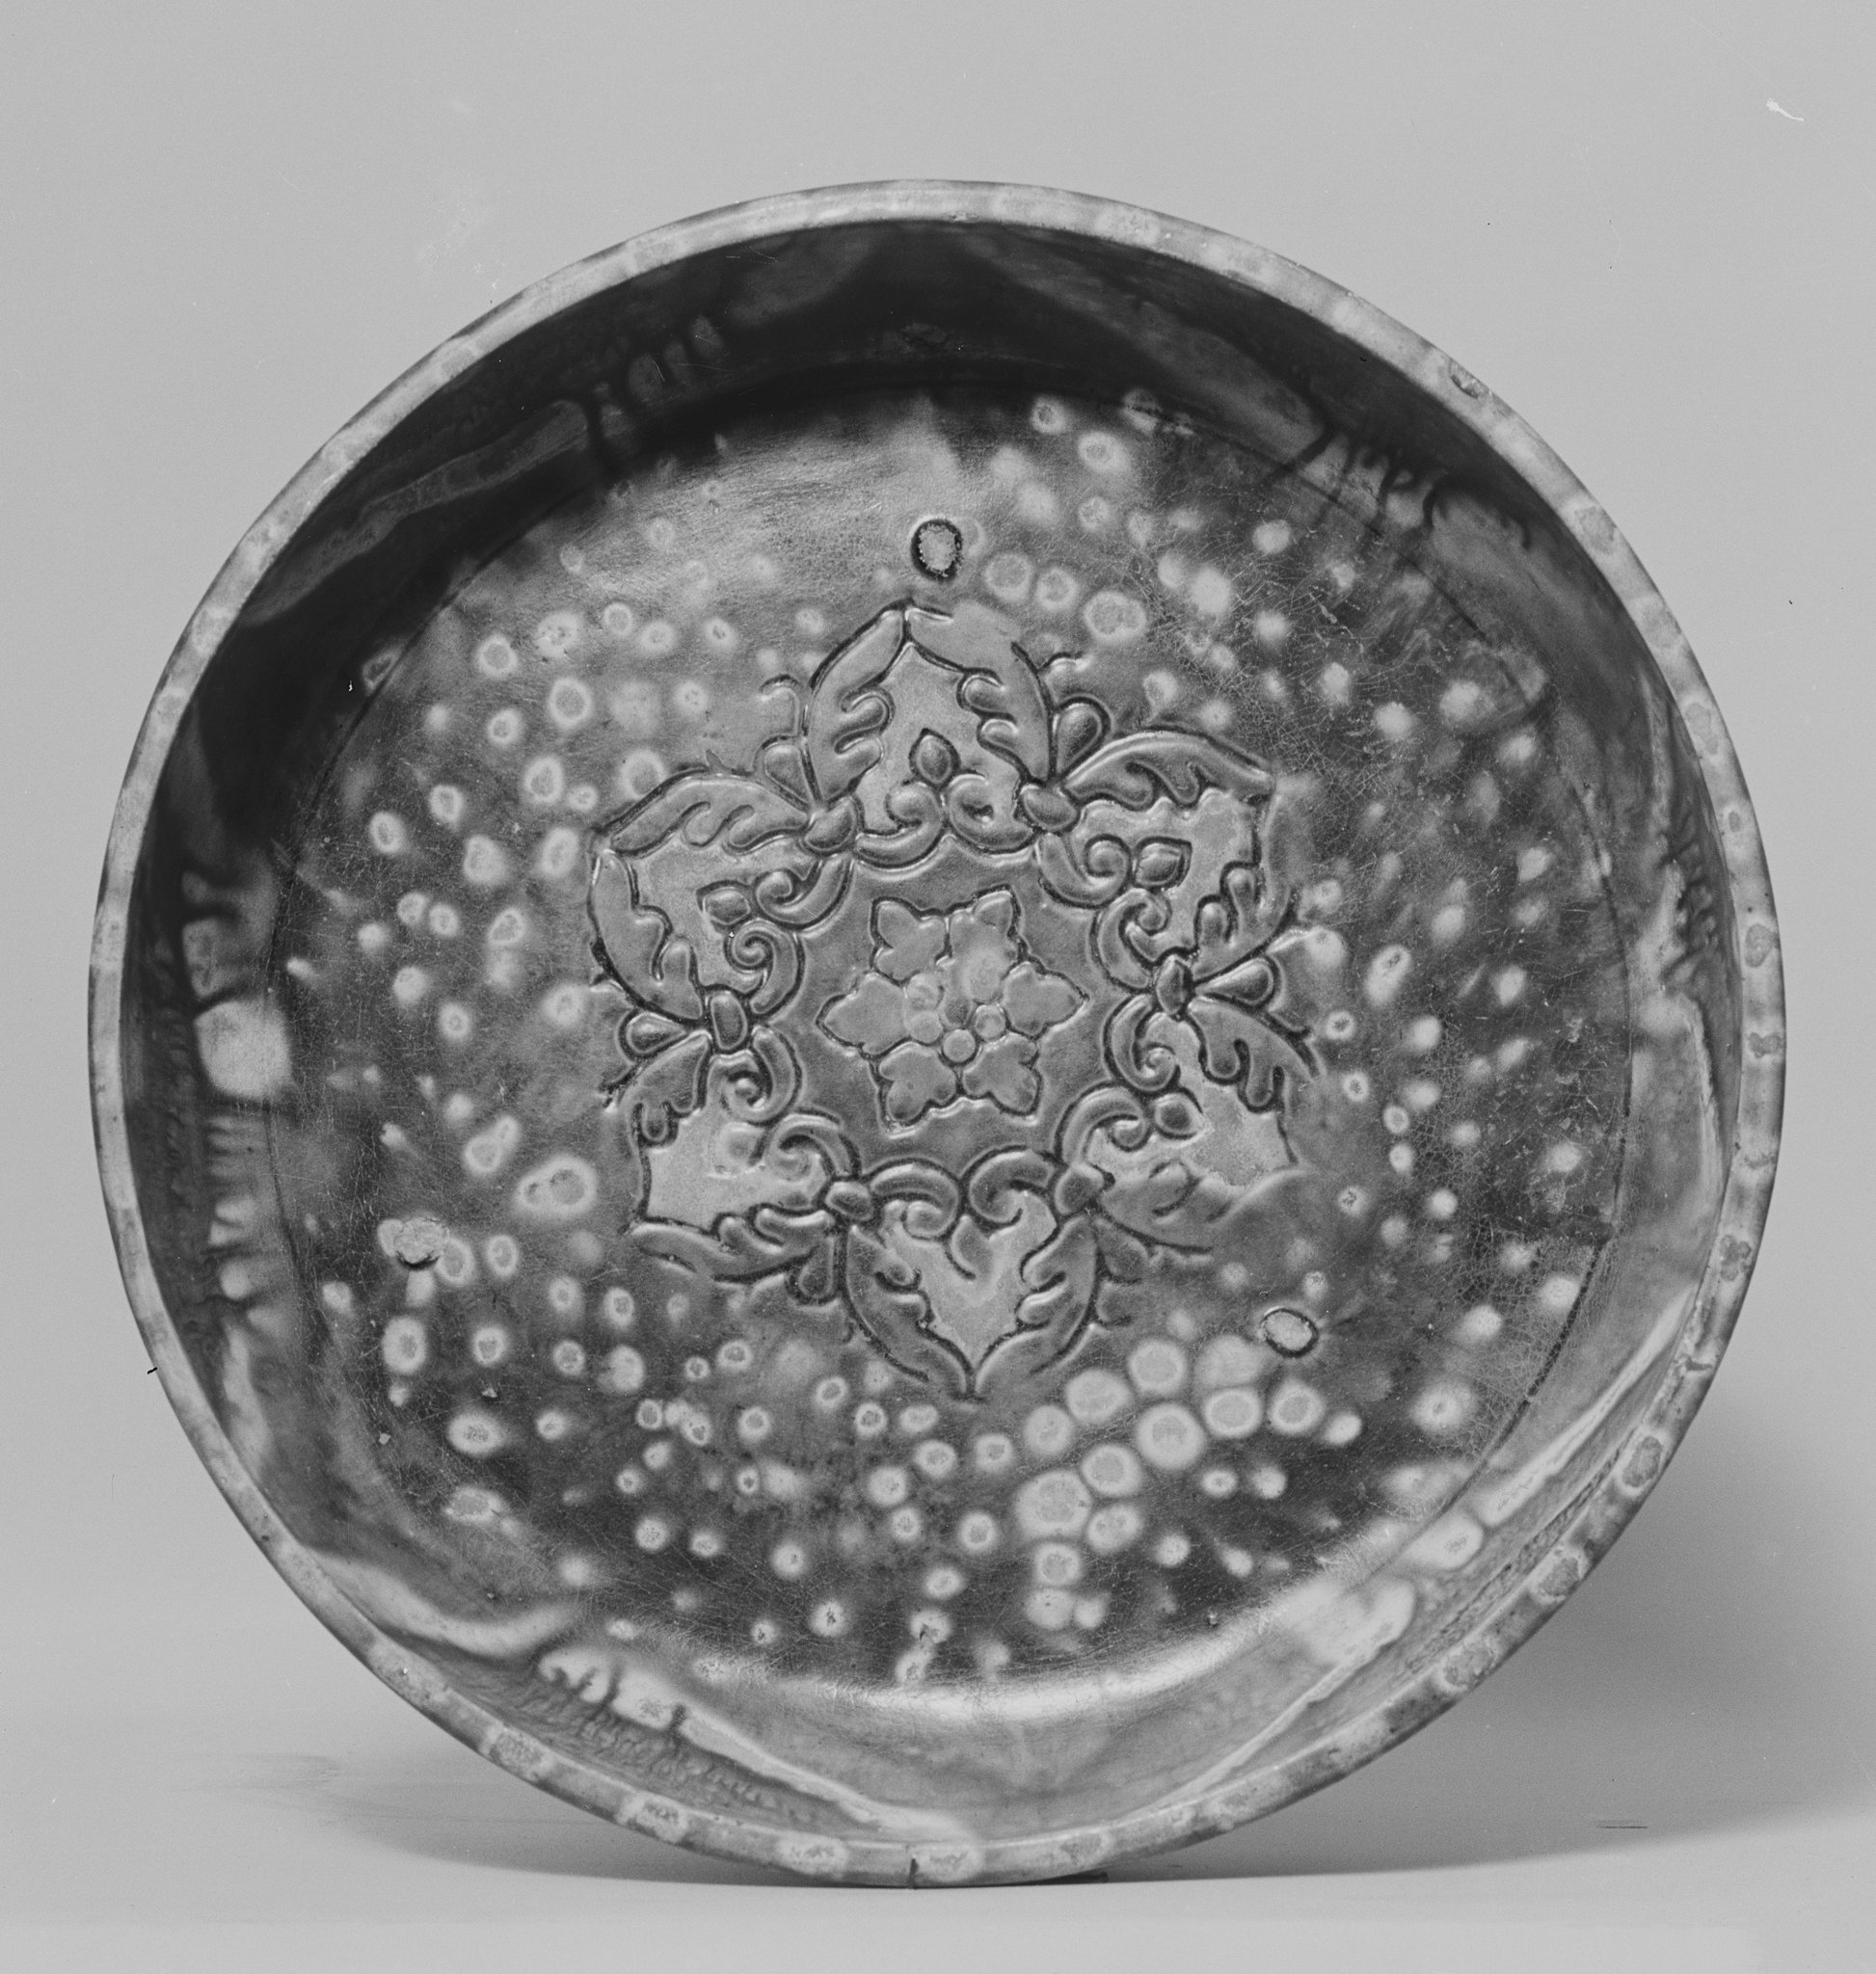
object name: dish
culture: chinese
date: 618-907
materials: earthenware, glaze